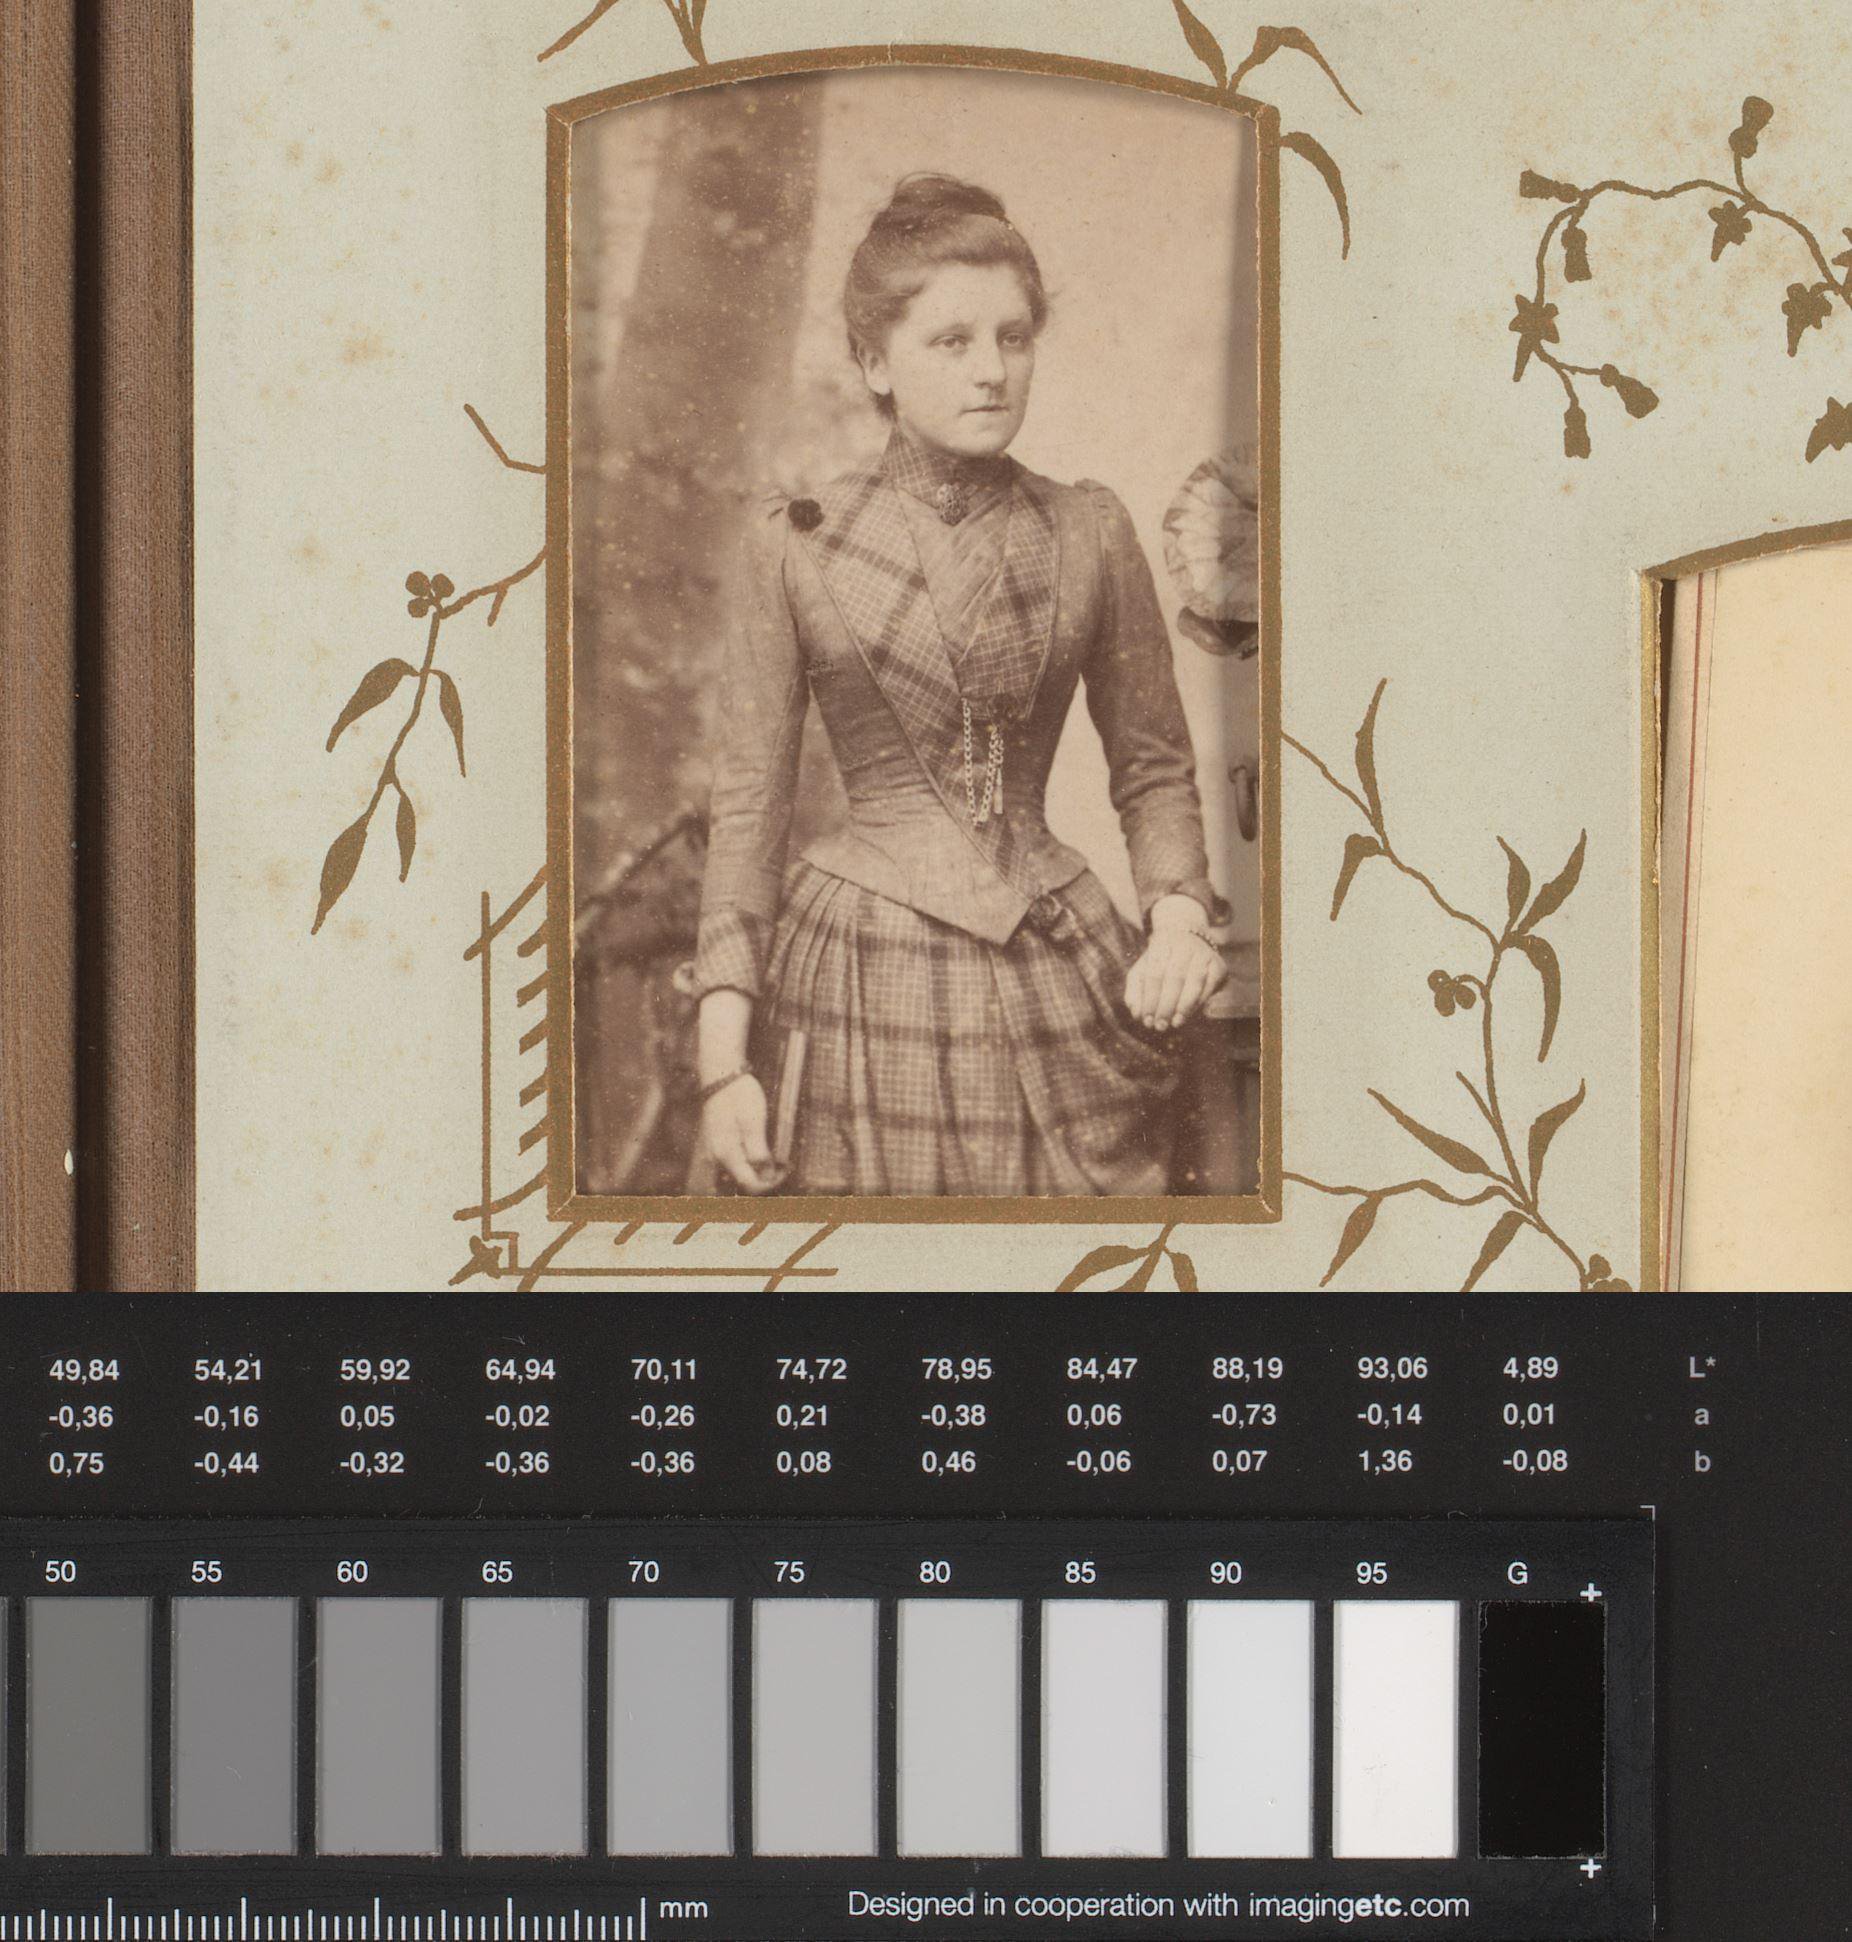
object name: carte de visite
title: Portret van een vrouw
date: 1860-1900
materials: cardboard, photographic support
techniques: albumen print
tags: adult woman, historical persons